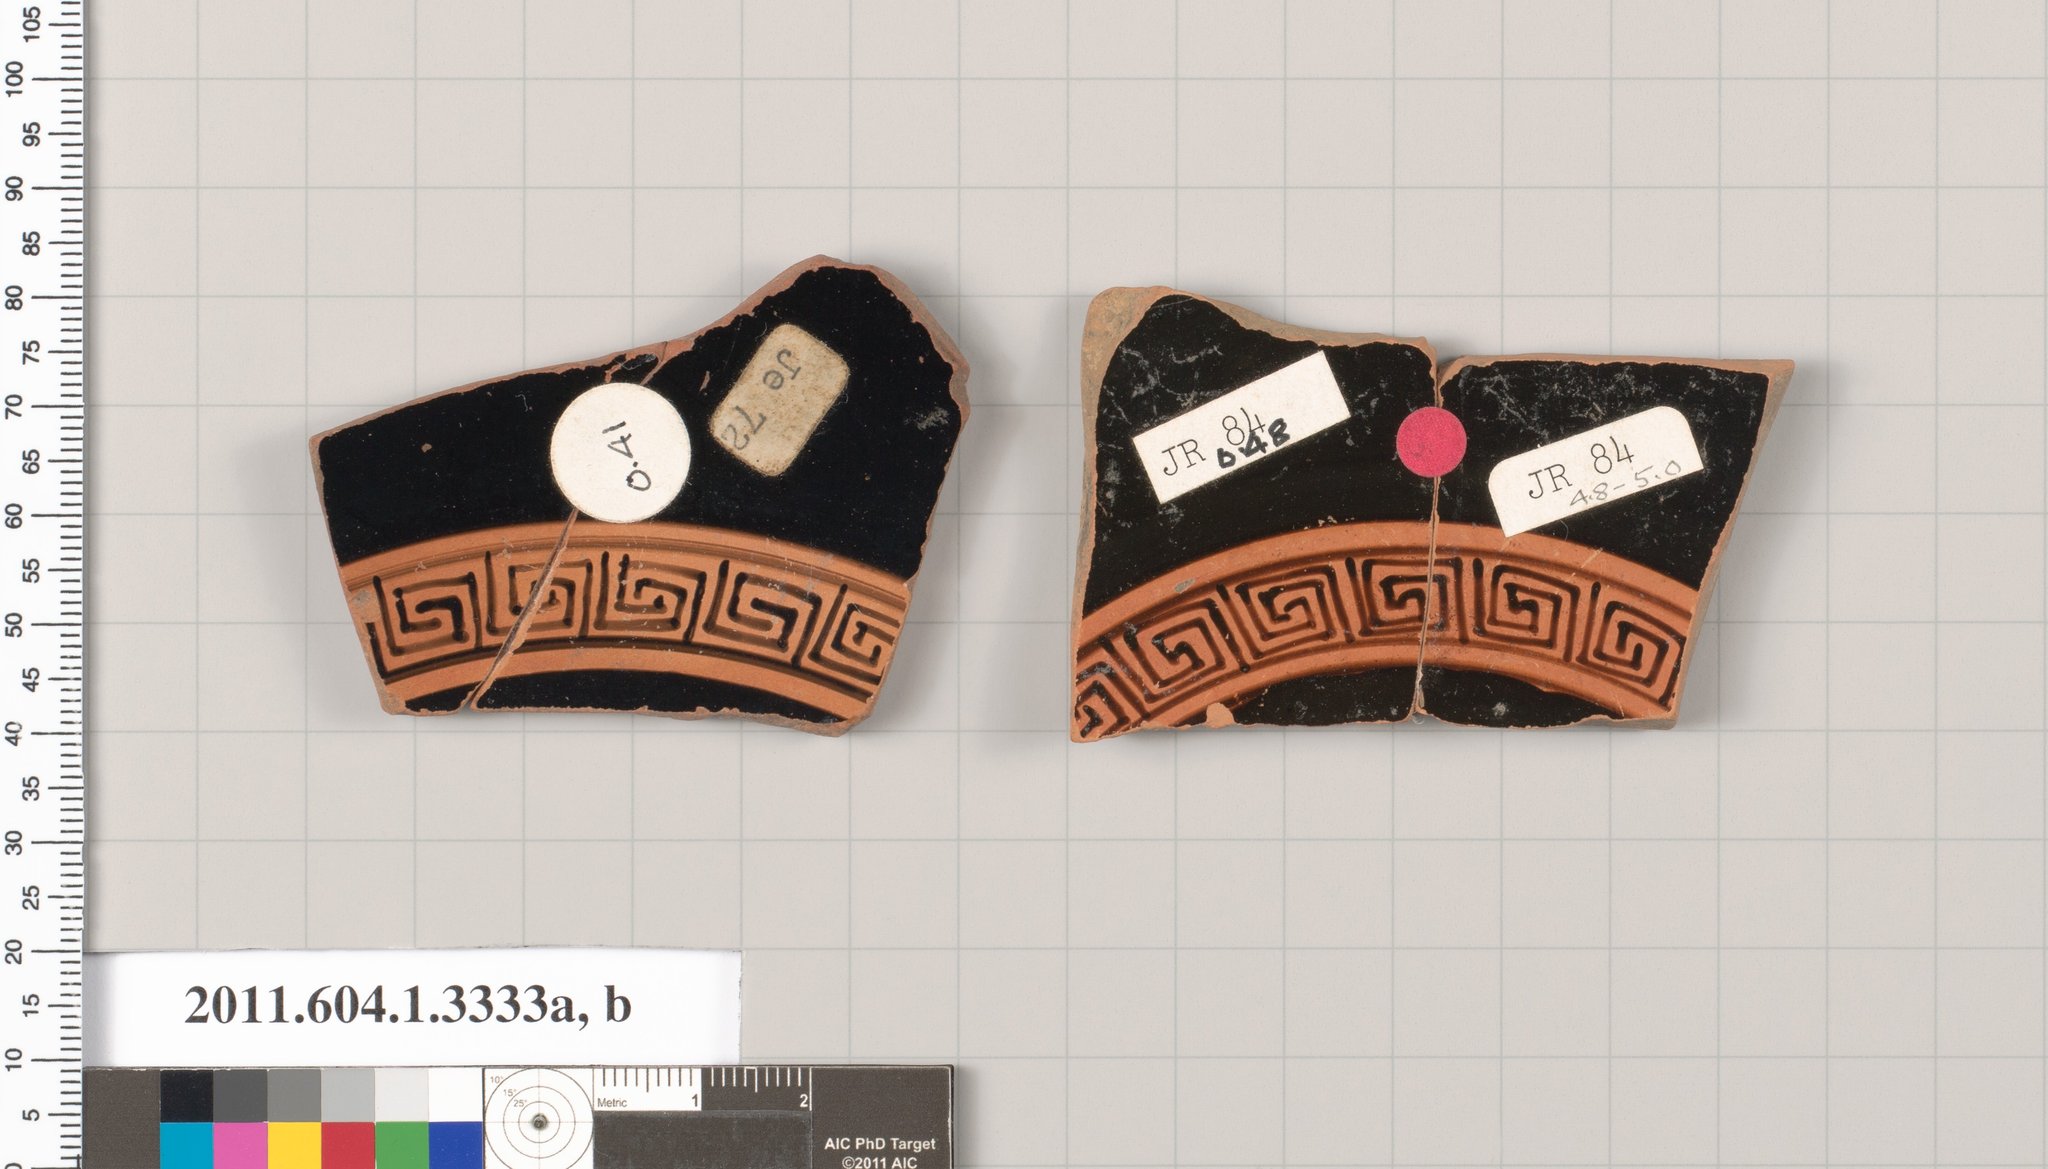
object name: kylix fragment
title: Terracotta fragments of kylikes (drinking cups)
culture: greek, attic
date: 500-470 BCE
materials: terracotta